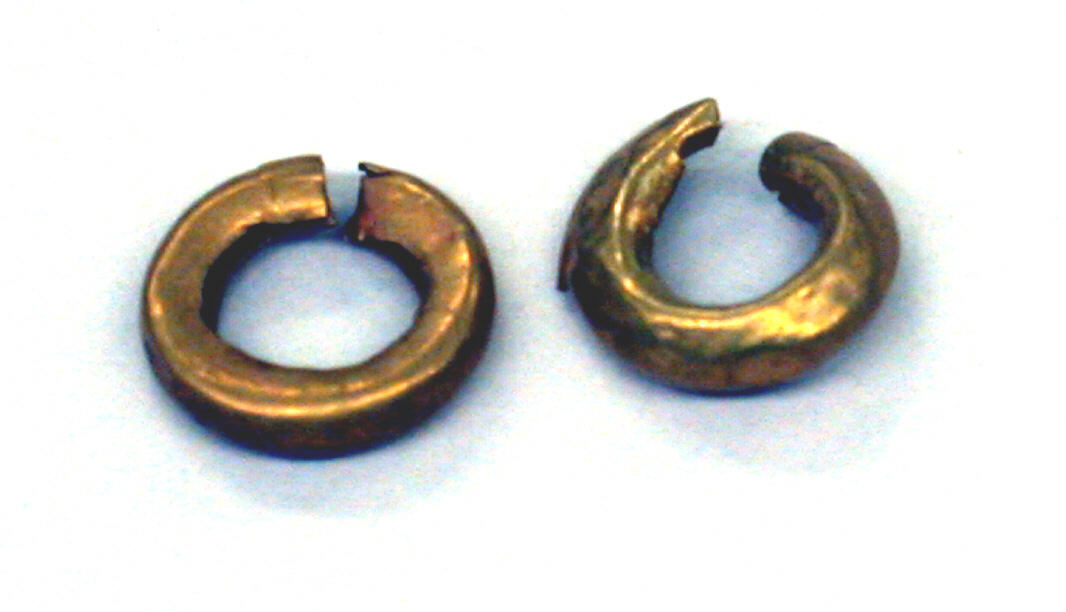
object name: ear ornament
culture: visayas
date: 1301-1500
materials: gold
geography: philippines